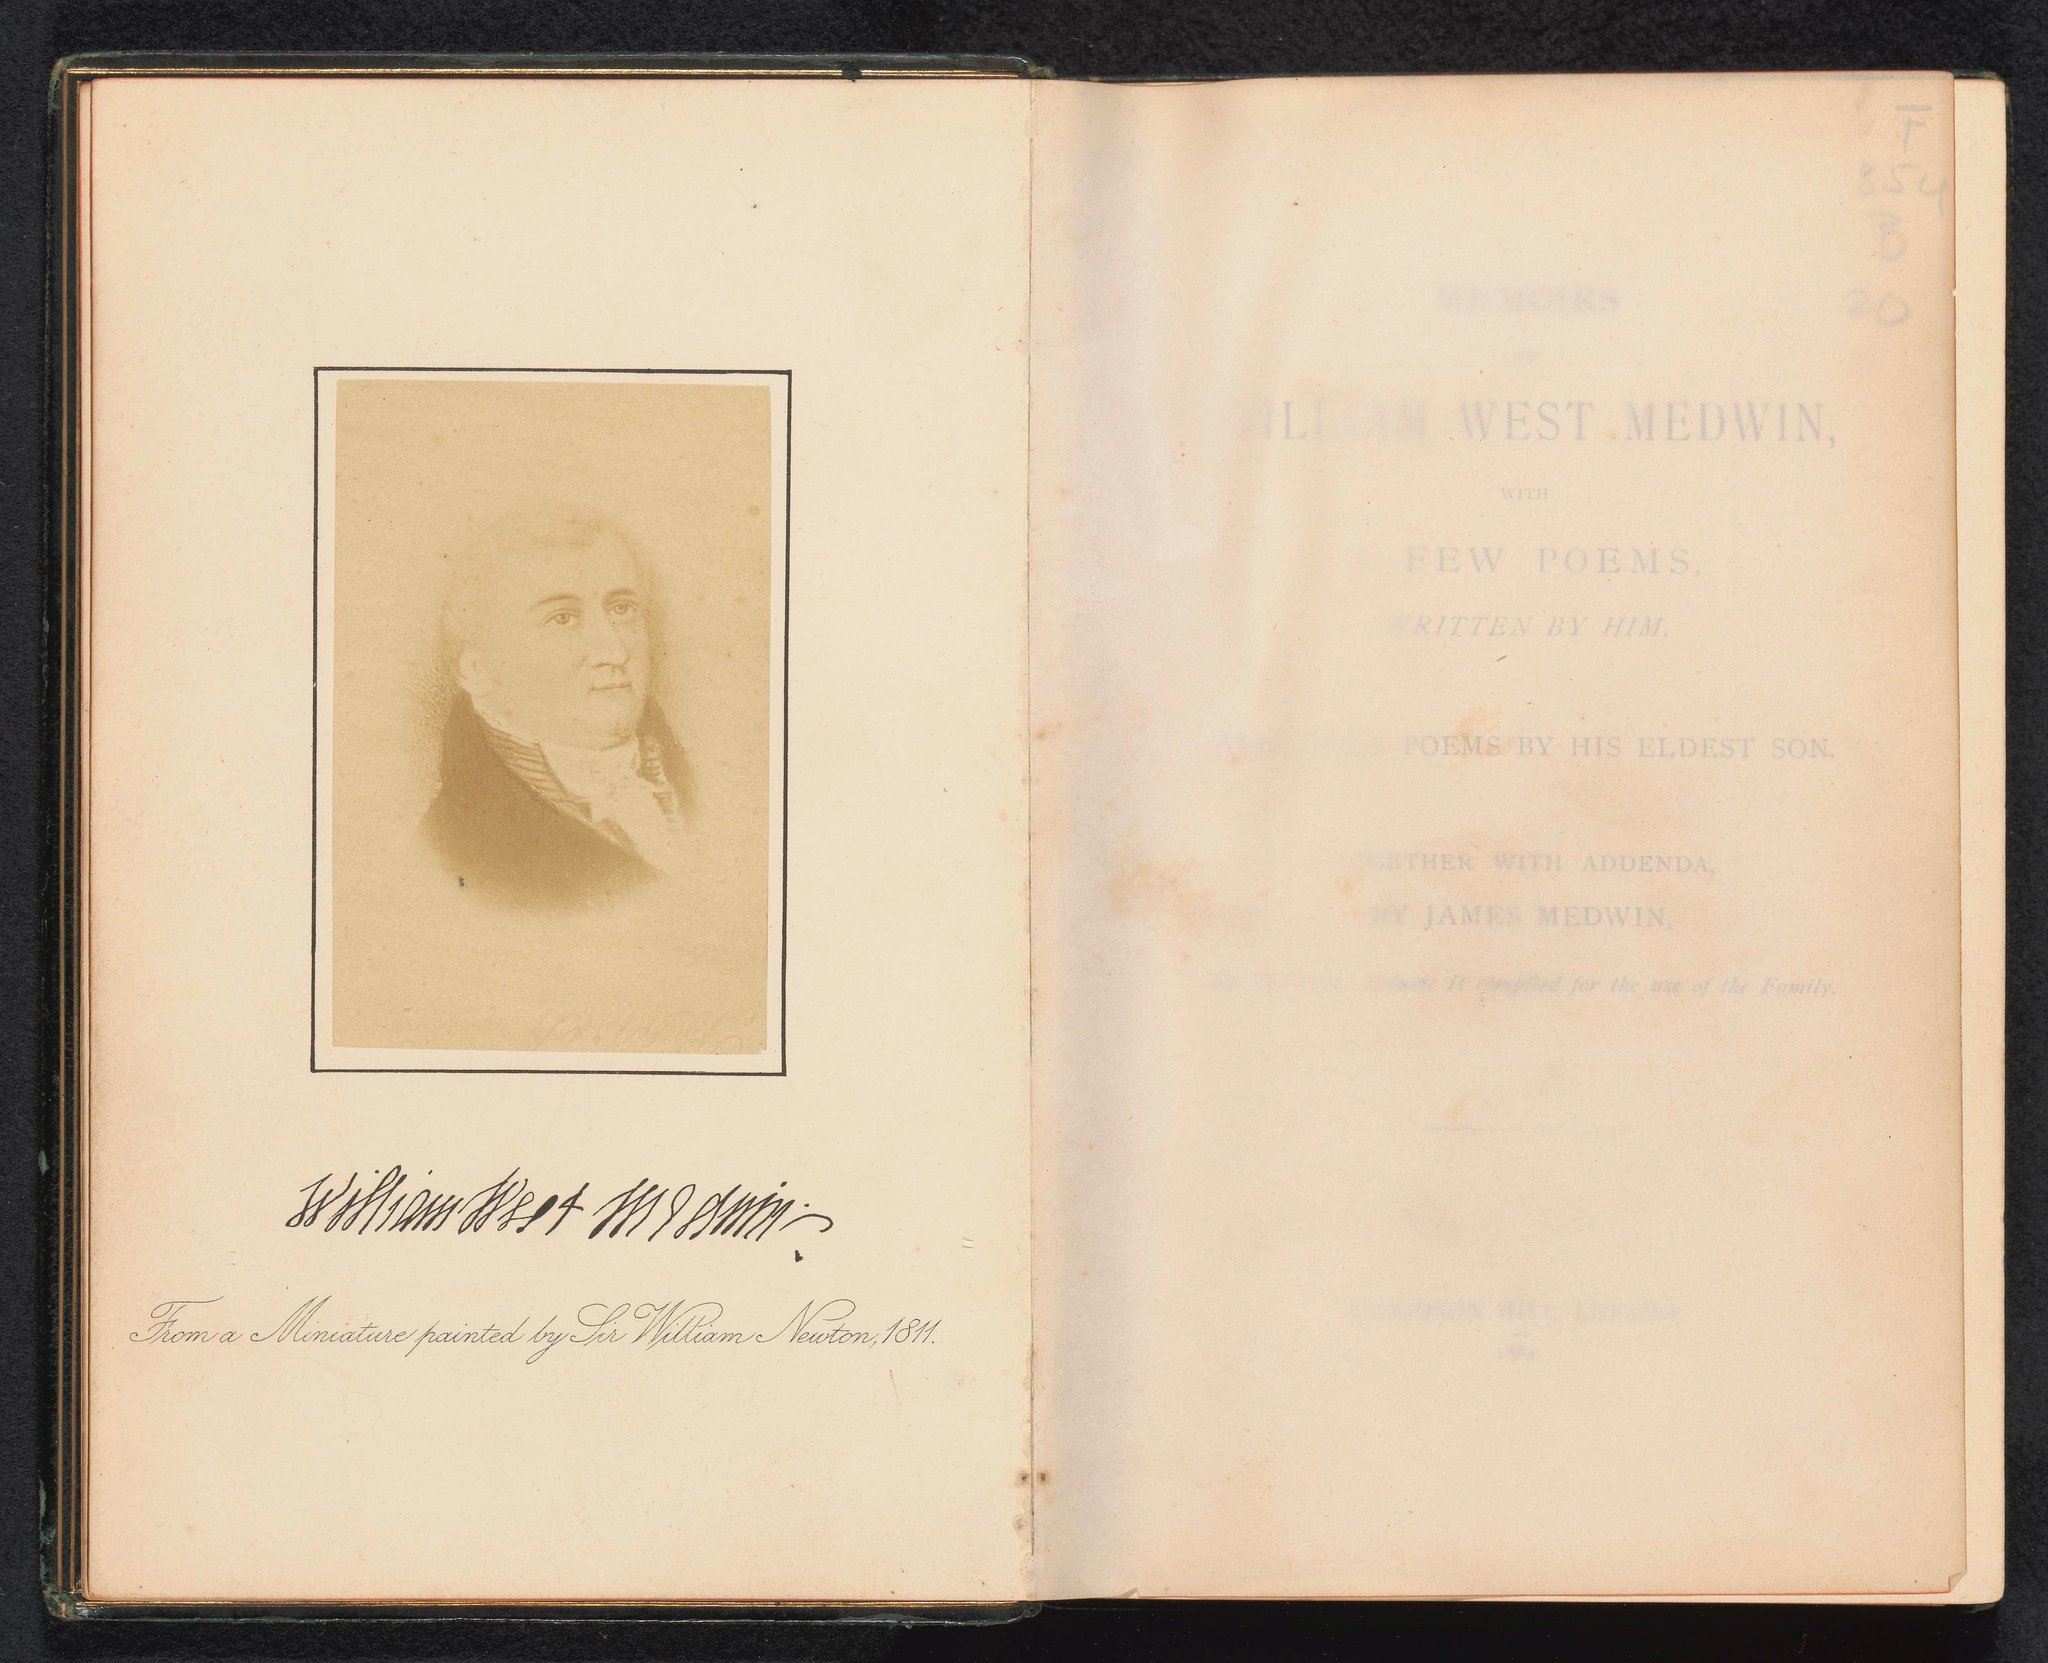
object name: page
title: Fotoreproductie van een schilderij, voorstellende een portret van William West Medwin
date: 1872-1882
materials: photographic support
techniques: albumen print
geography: london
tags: portrait of a writer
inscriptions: inscription: ‘Rives’, inscription: ‘William West Medwin’